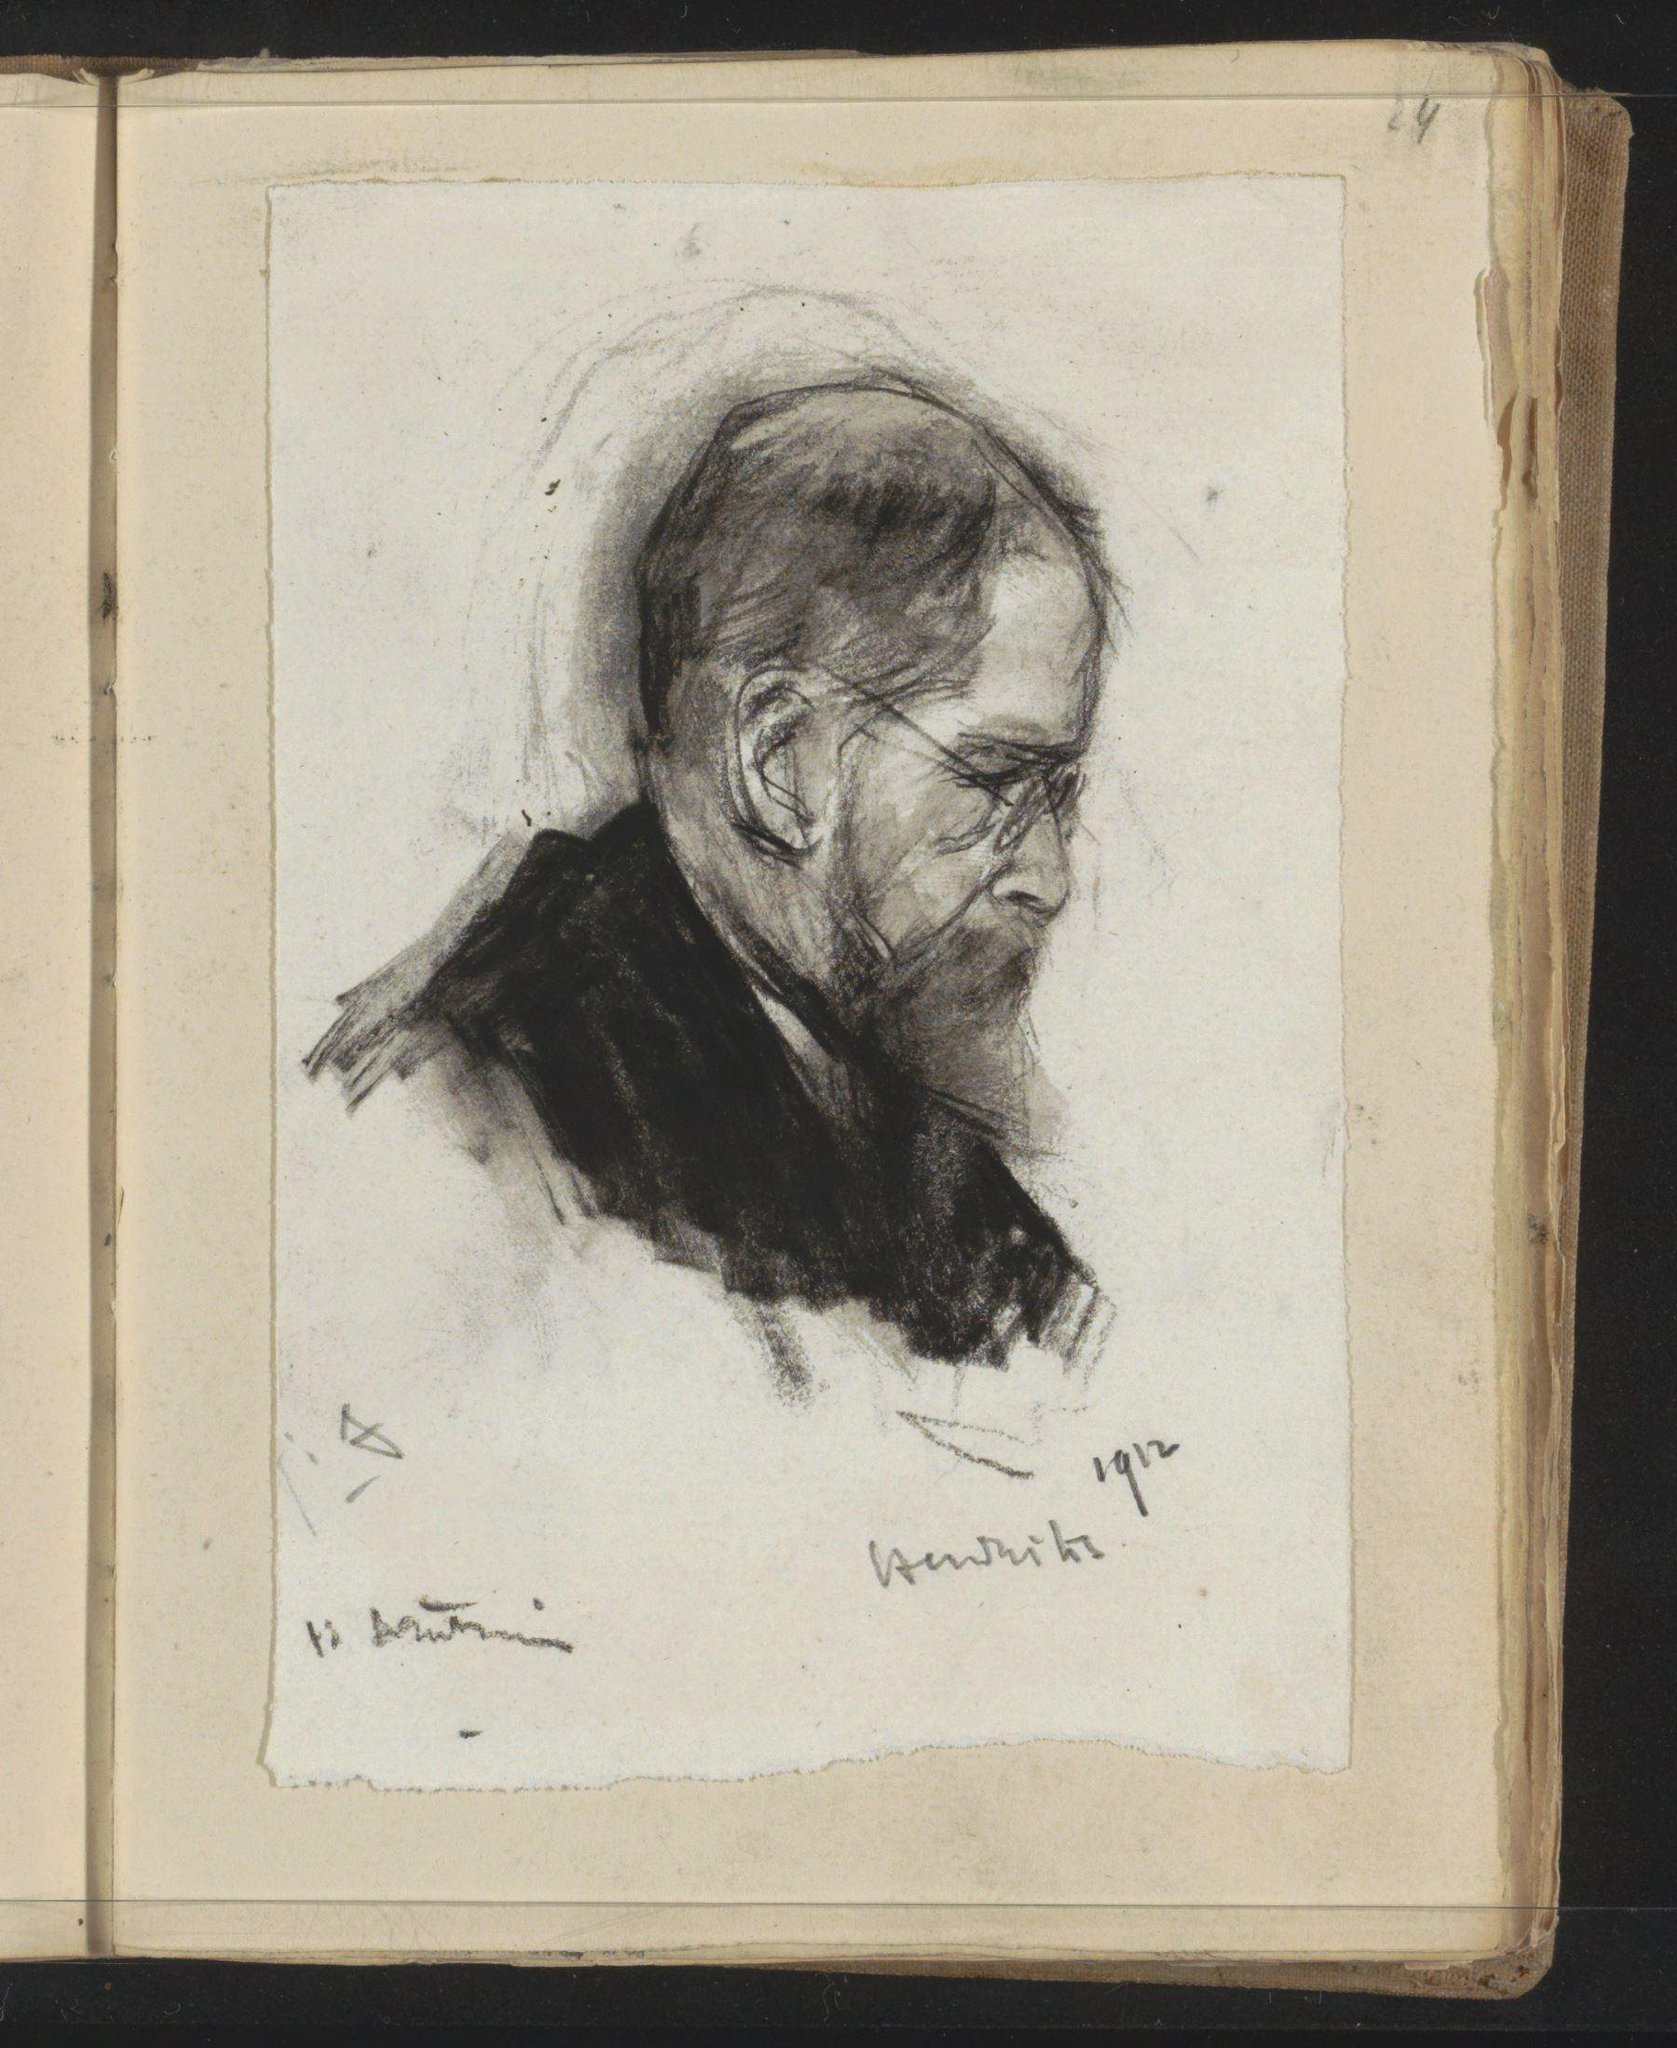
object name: sketchbook leaf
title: Portret van een man met bril, genaamd Hendriks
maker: floris arntzenius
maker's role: draughtsman, print maker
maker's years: 1864-1925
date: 1912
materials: chalk, paper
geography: the hague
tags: historical persons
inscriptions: signature: ‘Fl Arntzenius’, date: ‘1912’, name: ‘Hendriks’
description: Blad, geplakt op pagina 24 uit een schetsboek met 82 pagina's.